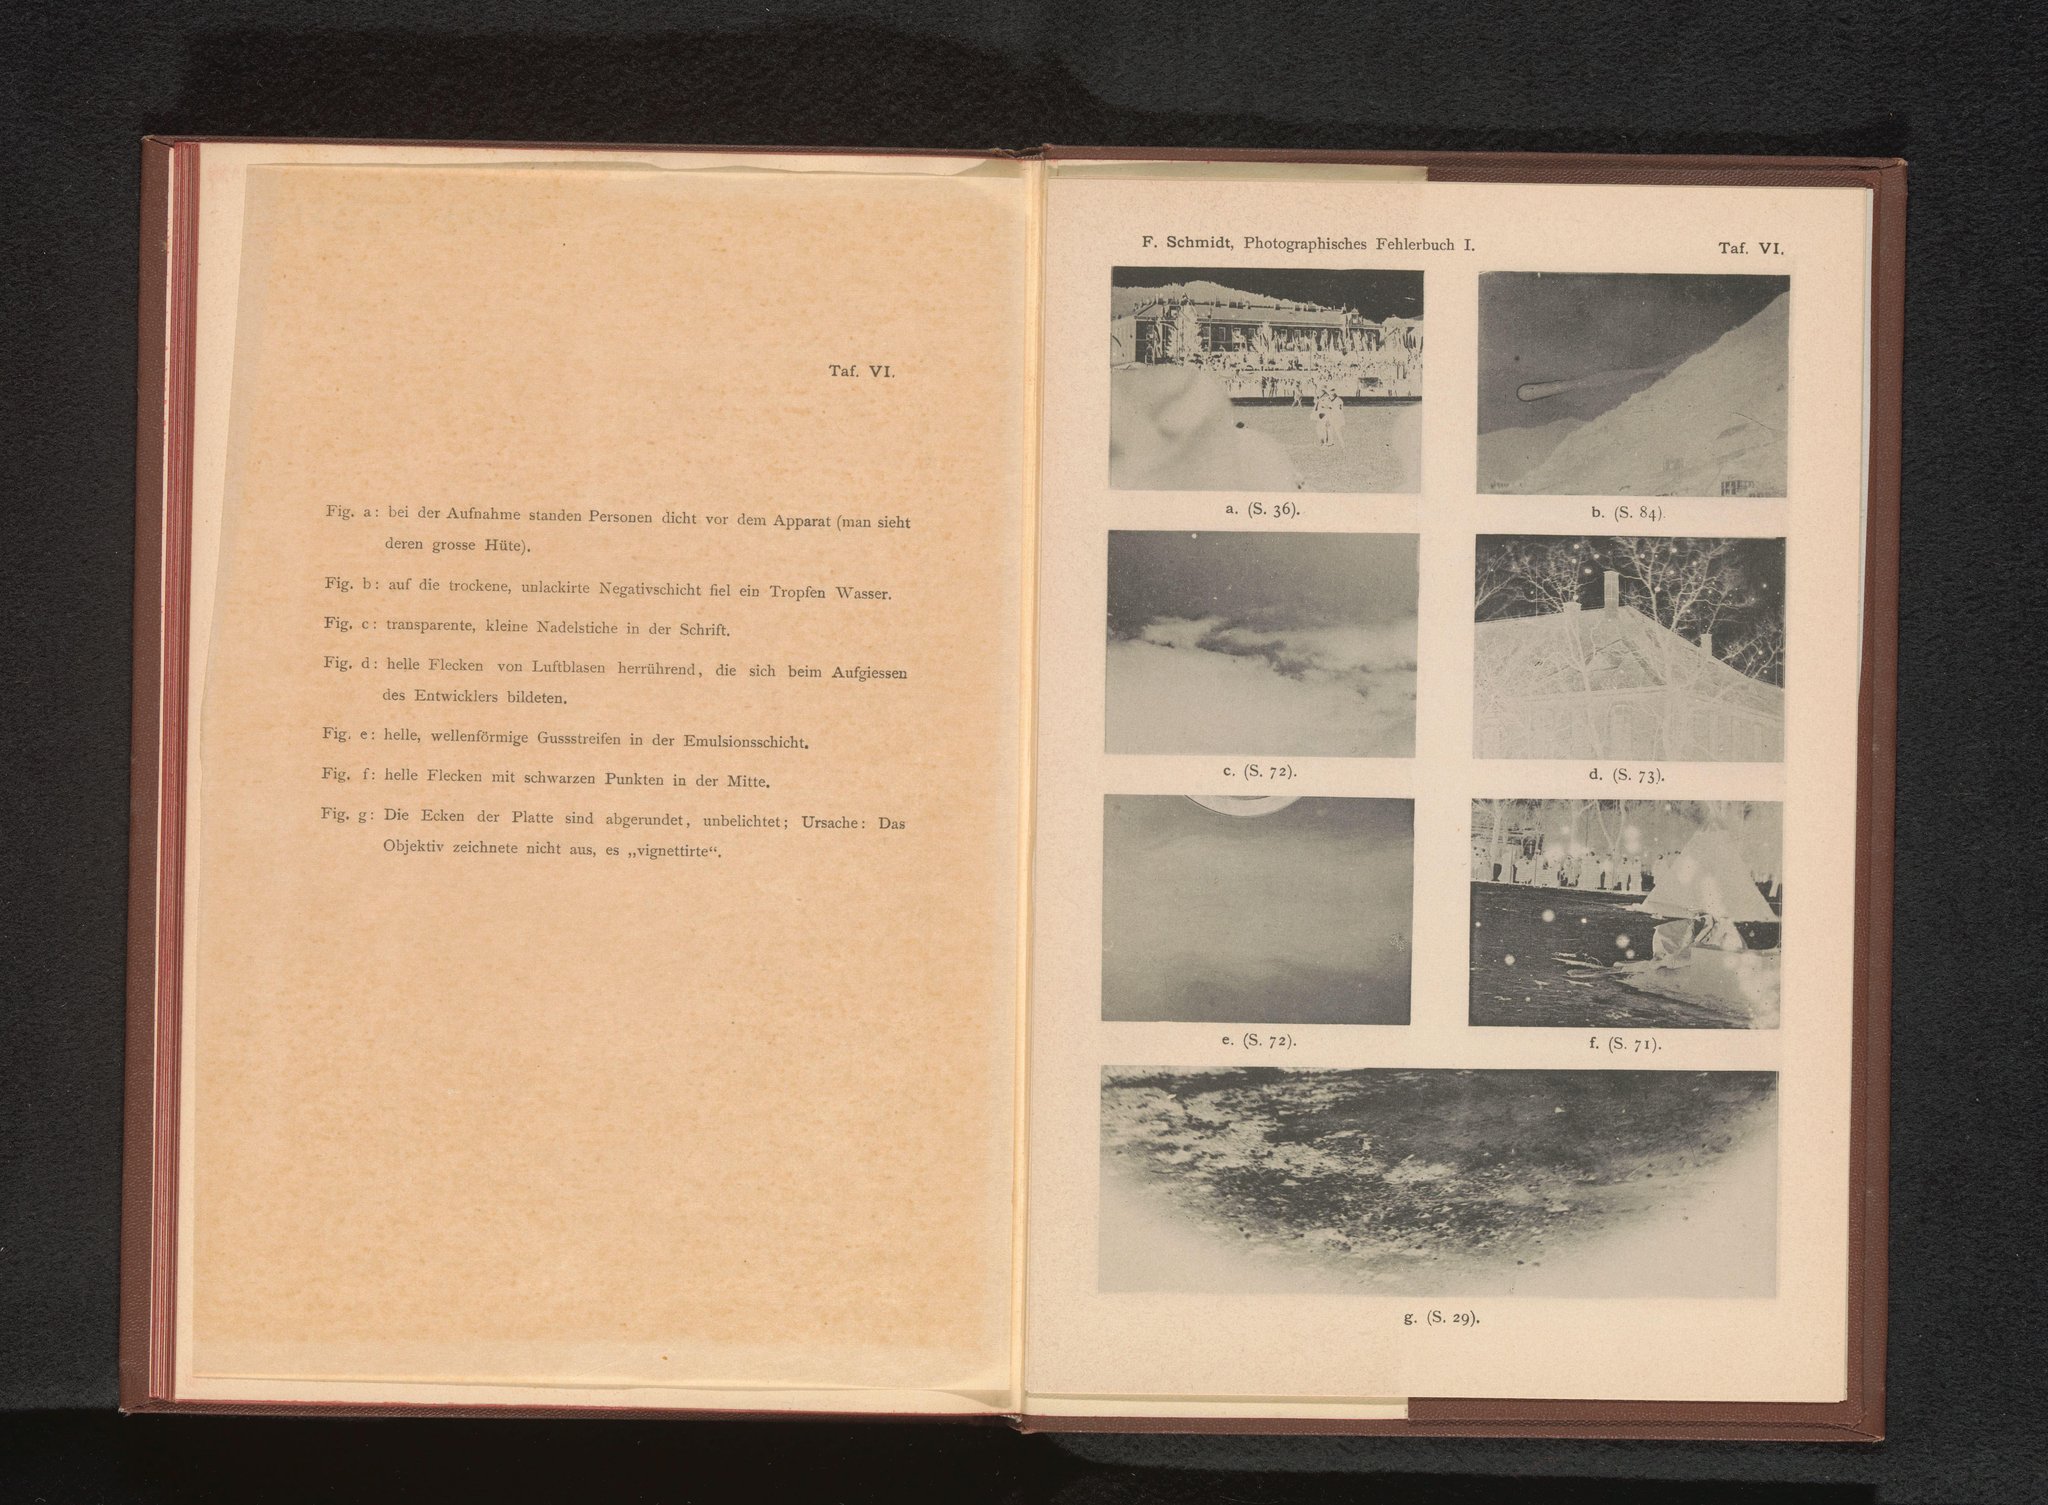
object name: photomechanical print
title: Zeven voorbeelden van onvolkomenheden in negatieven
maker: Anonymous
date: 1890-1895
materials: paper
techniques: photograph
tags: negative ~ photography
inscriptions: number: ‘Taf. VI.’, inscription: ‘a. (S. 36). b. (S. 84)./ c. (S. 72). d. (S. 73)./ e. (S. 72). f. (S. 71)./ g. (S 29).’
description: Prenten op losse bladen. Bladen in insteekhoes achterin boek.